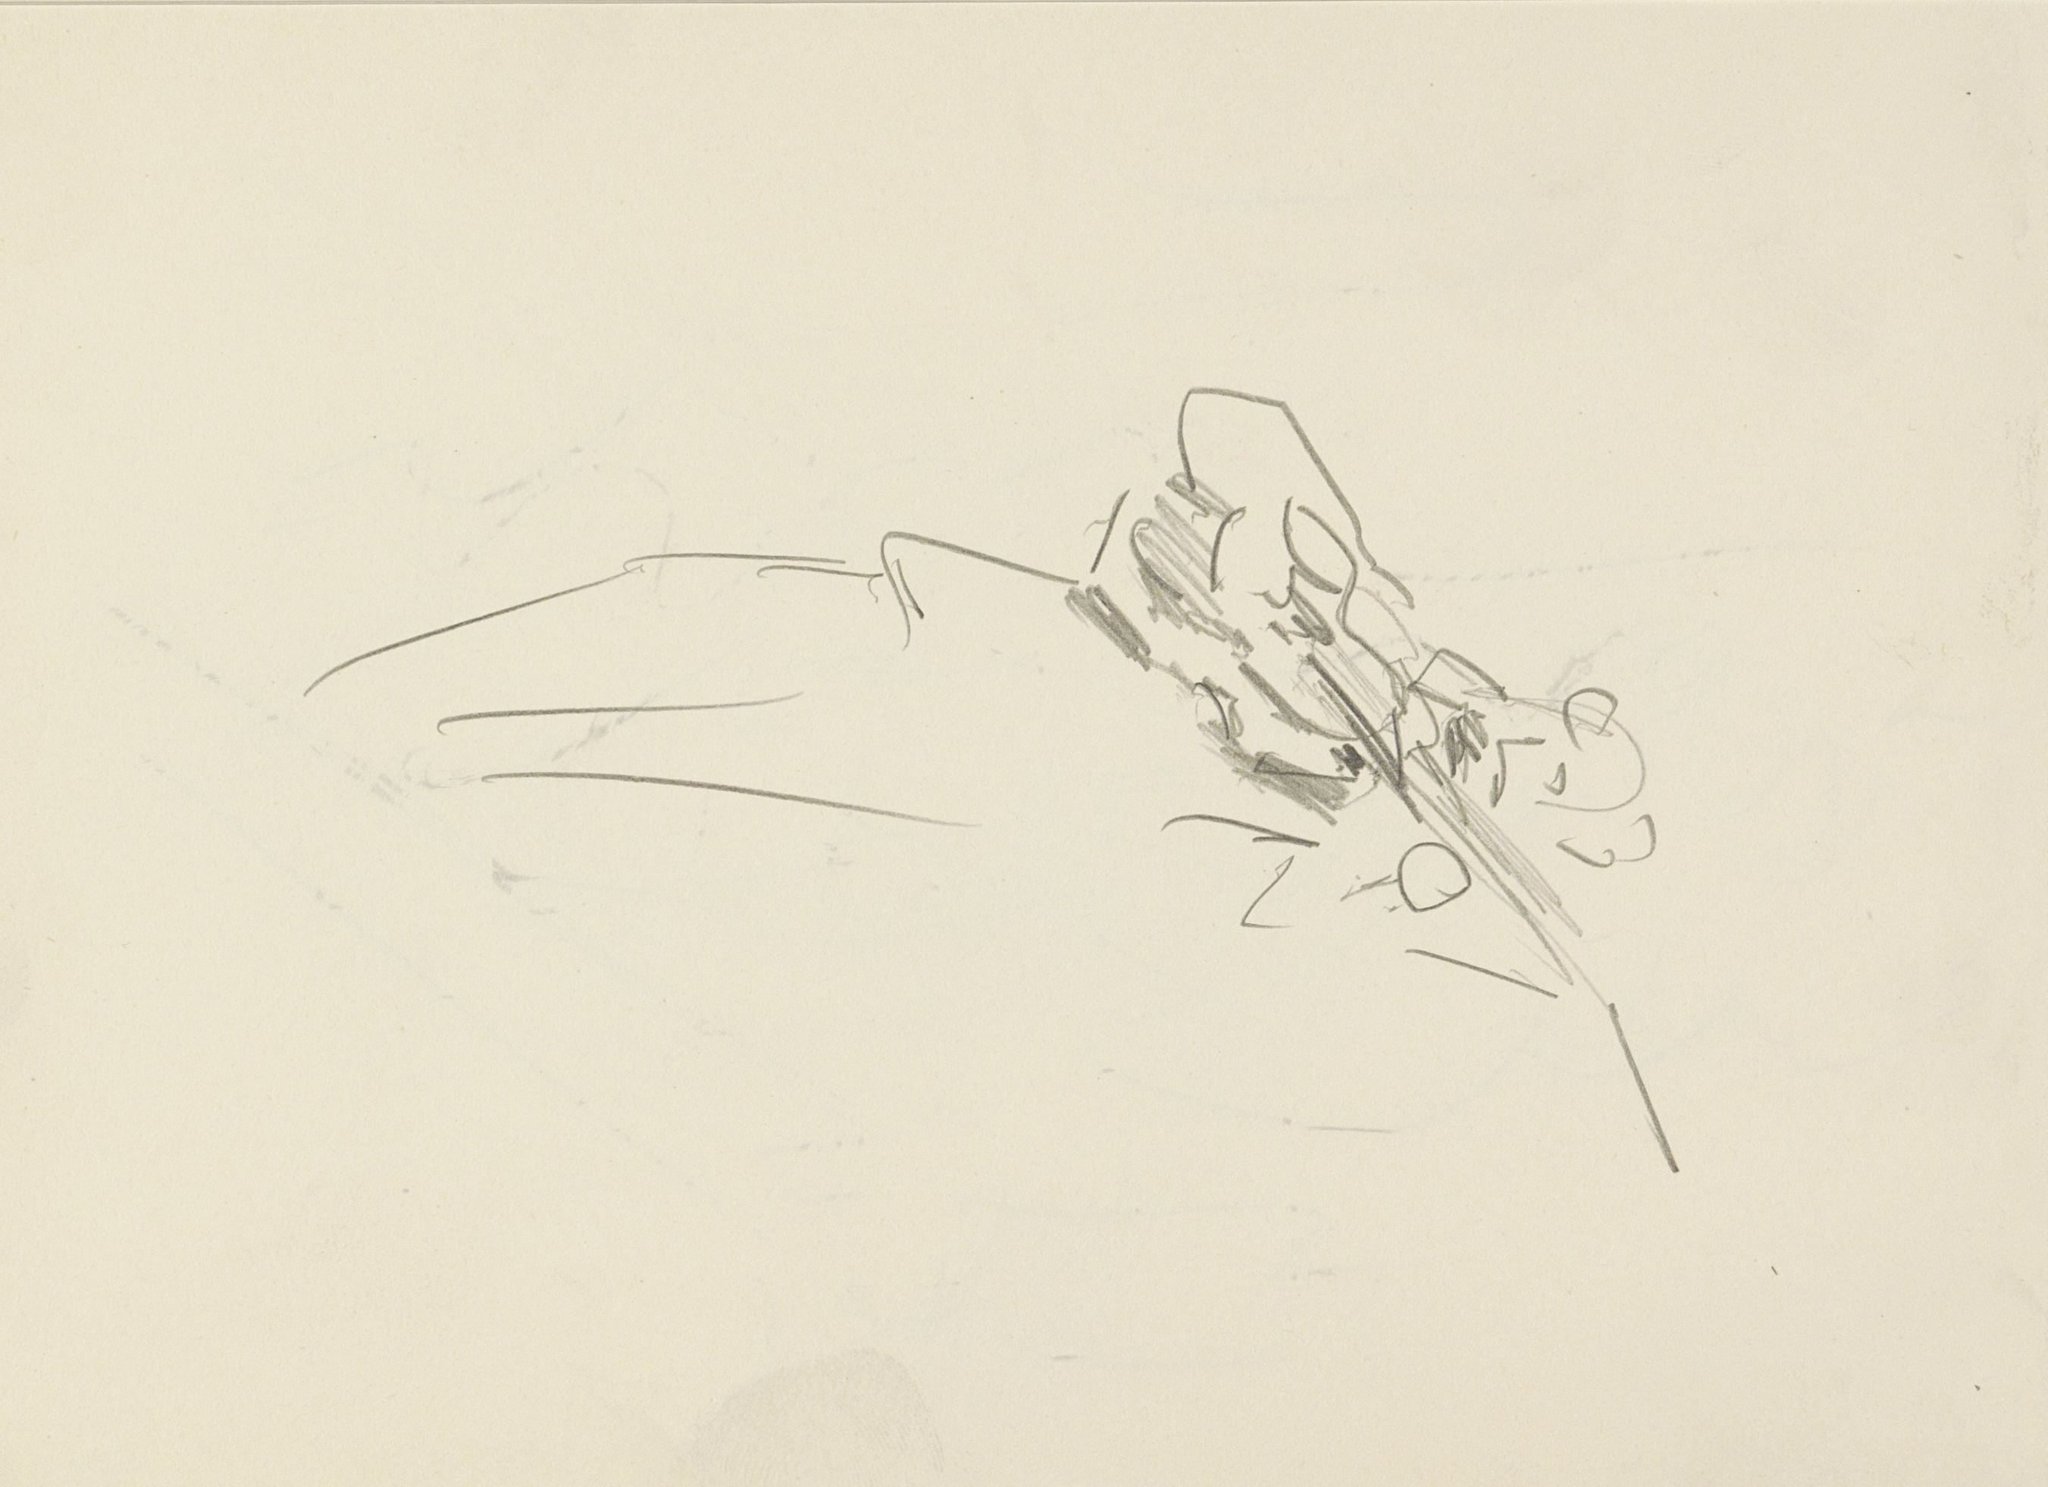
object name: sketchbook leaf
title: Gitaarspeler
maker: isaac israels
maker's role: draughtsman, painter, print maker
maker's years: 1865-1934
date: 1930-1934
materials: paper, pencil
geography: the hague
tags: cithern, mandolin, guitar, balalaika (+ artist at work)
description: De man speelt gitaar of een aanverwant snaarinstrument. Blad 4 verso uit schetsboek I met 26 bladen.